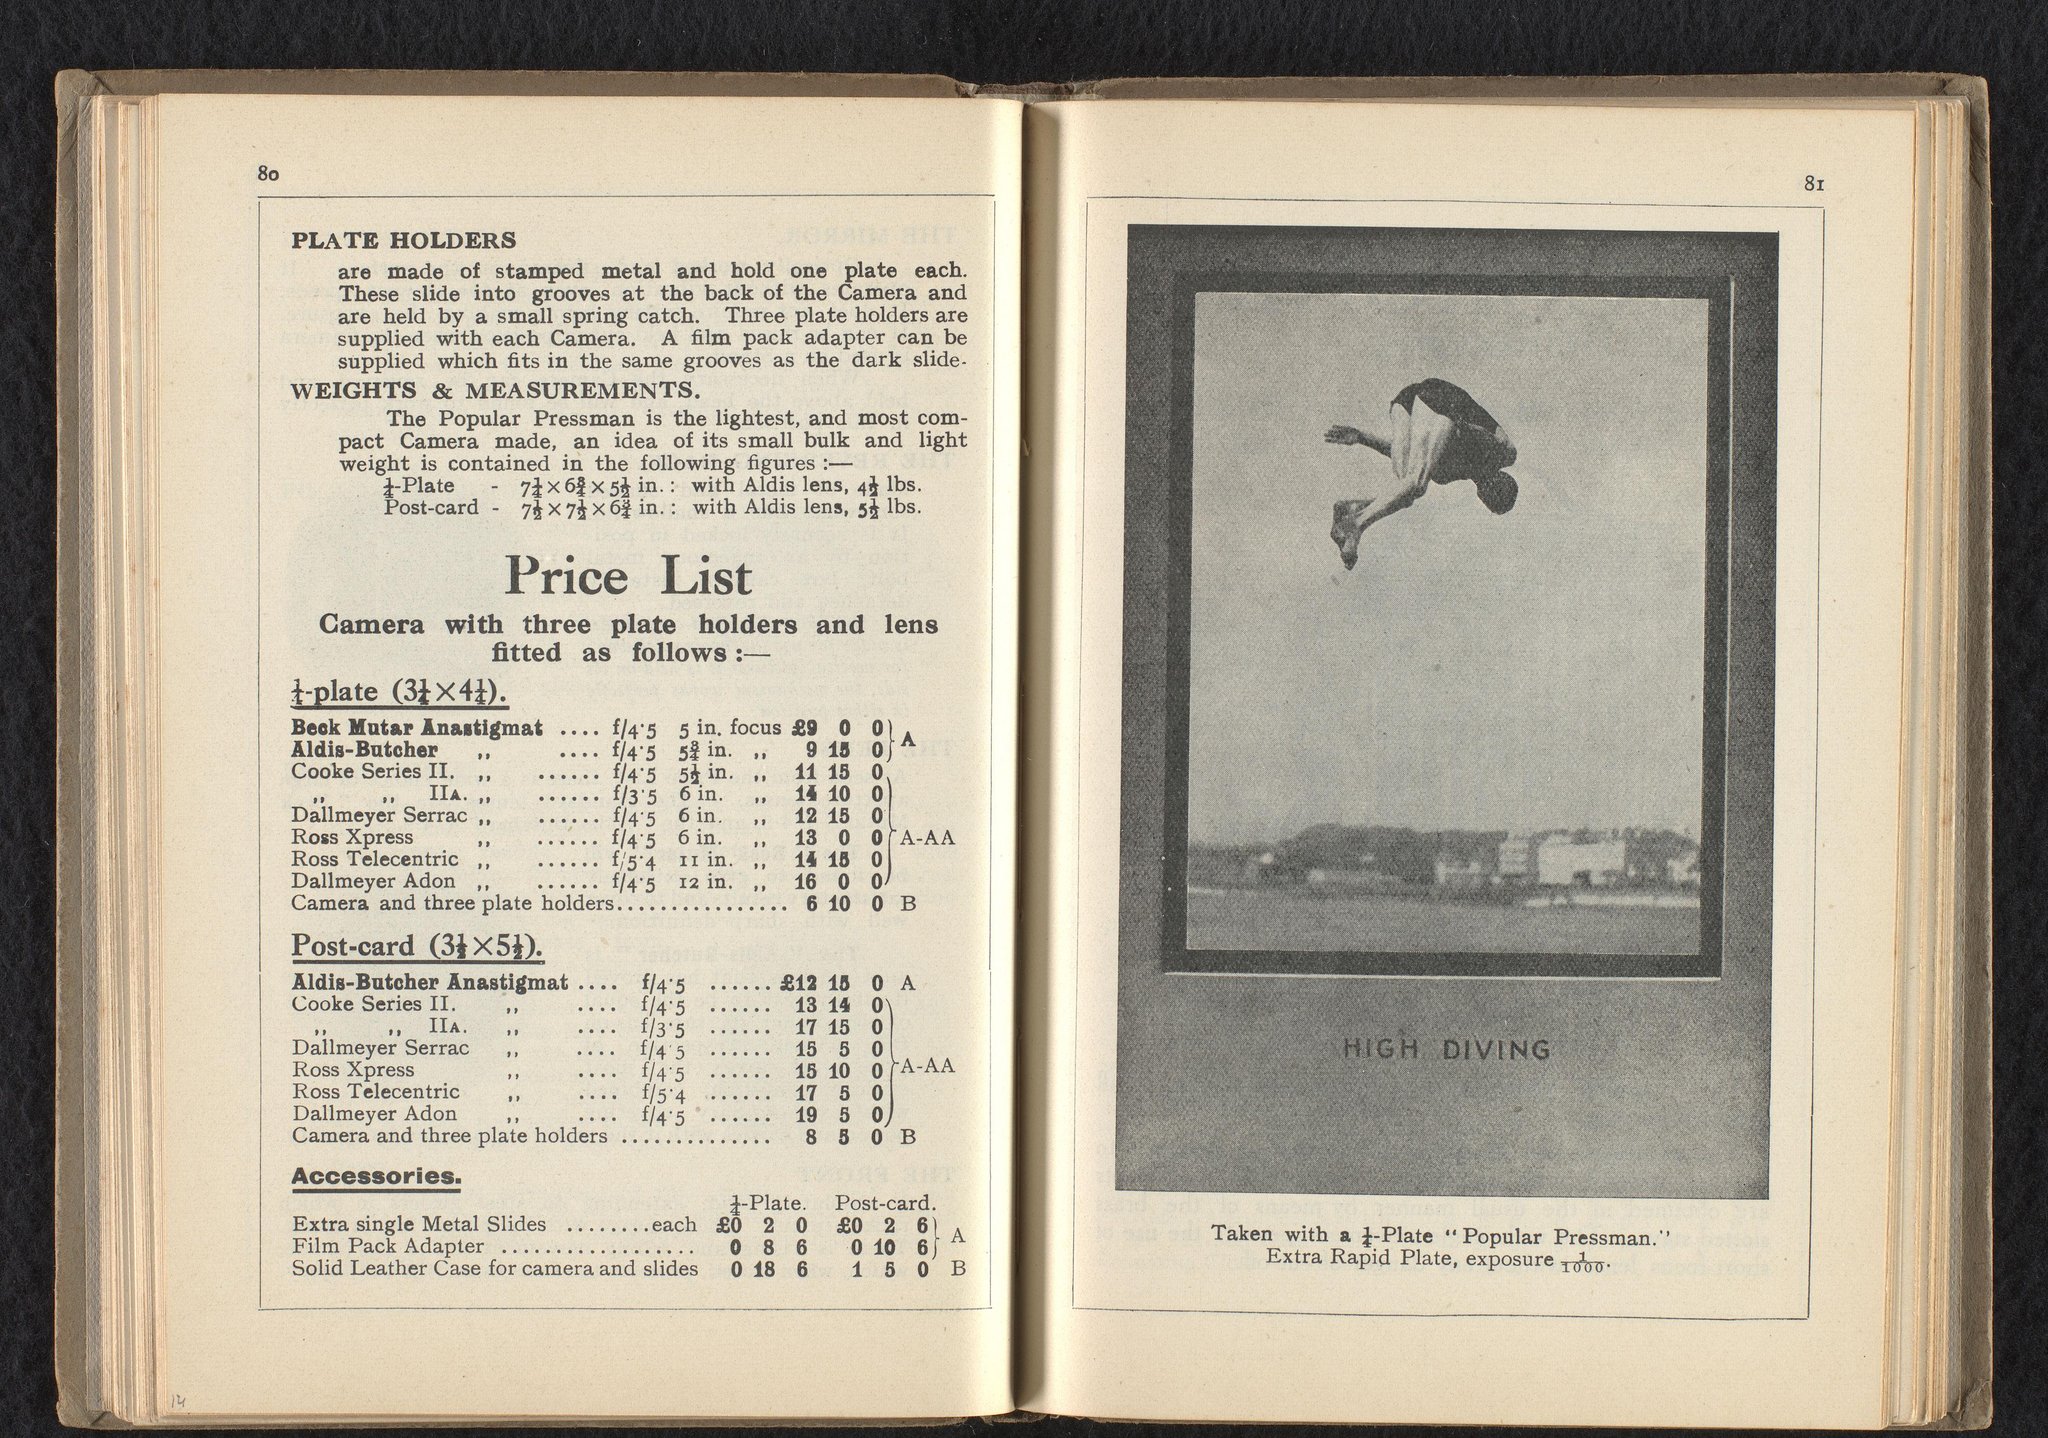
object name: photomechanical print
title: Duiker tijdens hoogspringen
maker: Anonymous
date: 1907-1912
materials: paper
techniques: letterpress printing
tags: diving (sport)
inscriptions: inscription: ‘Taken with a 1/4-Plate "Popular Pressman." Extra Rapid Plate, exposure 1/1000.’